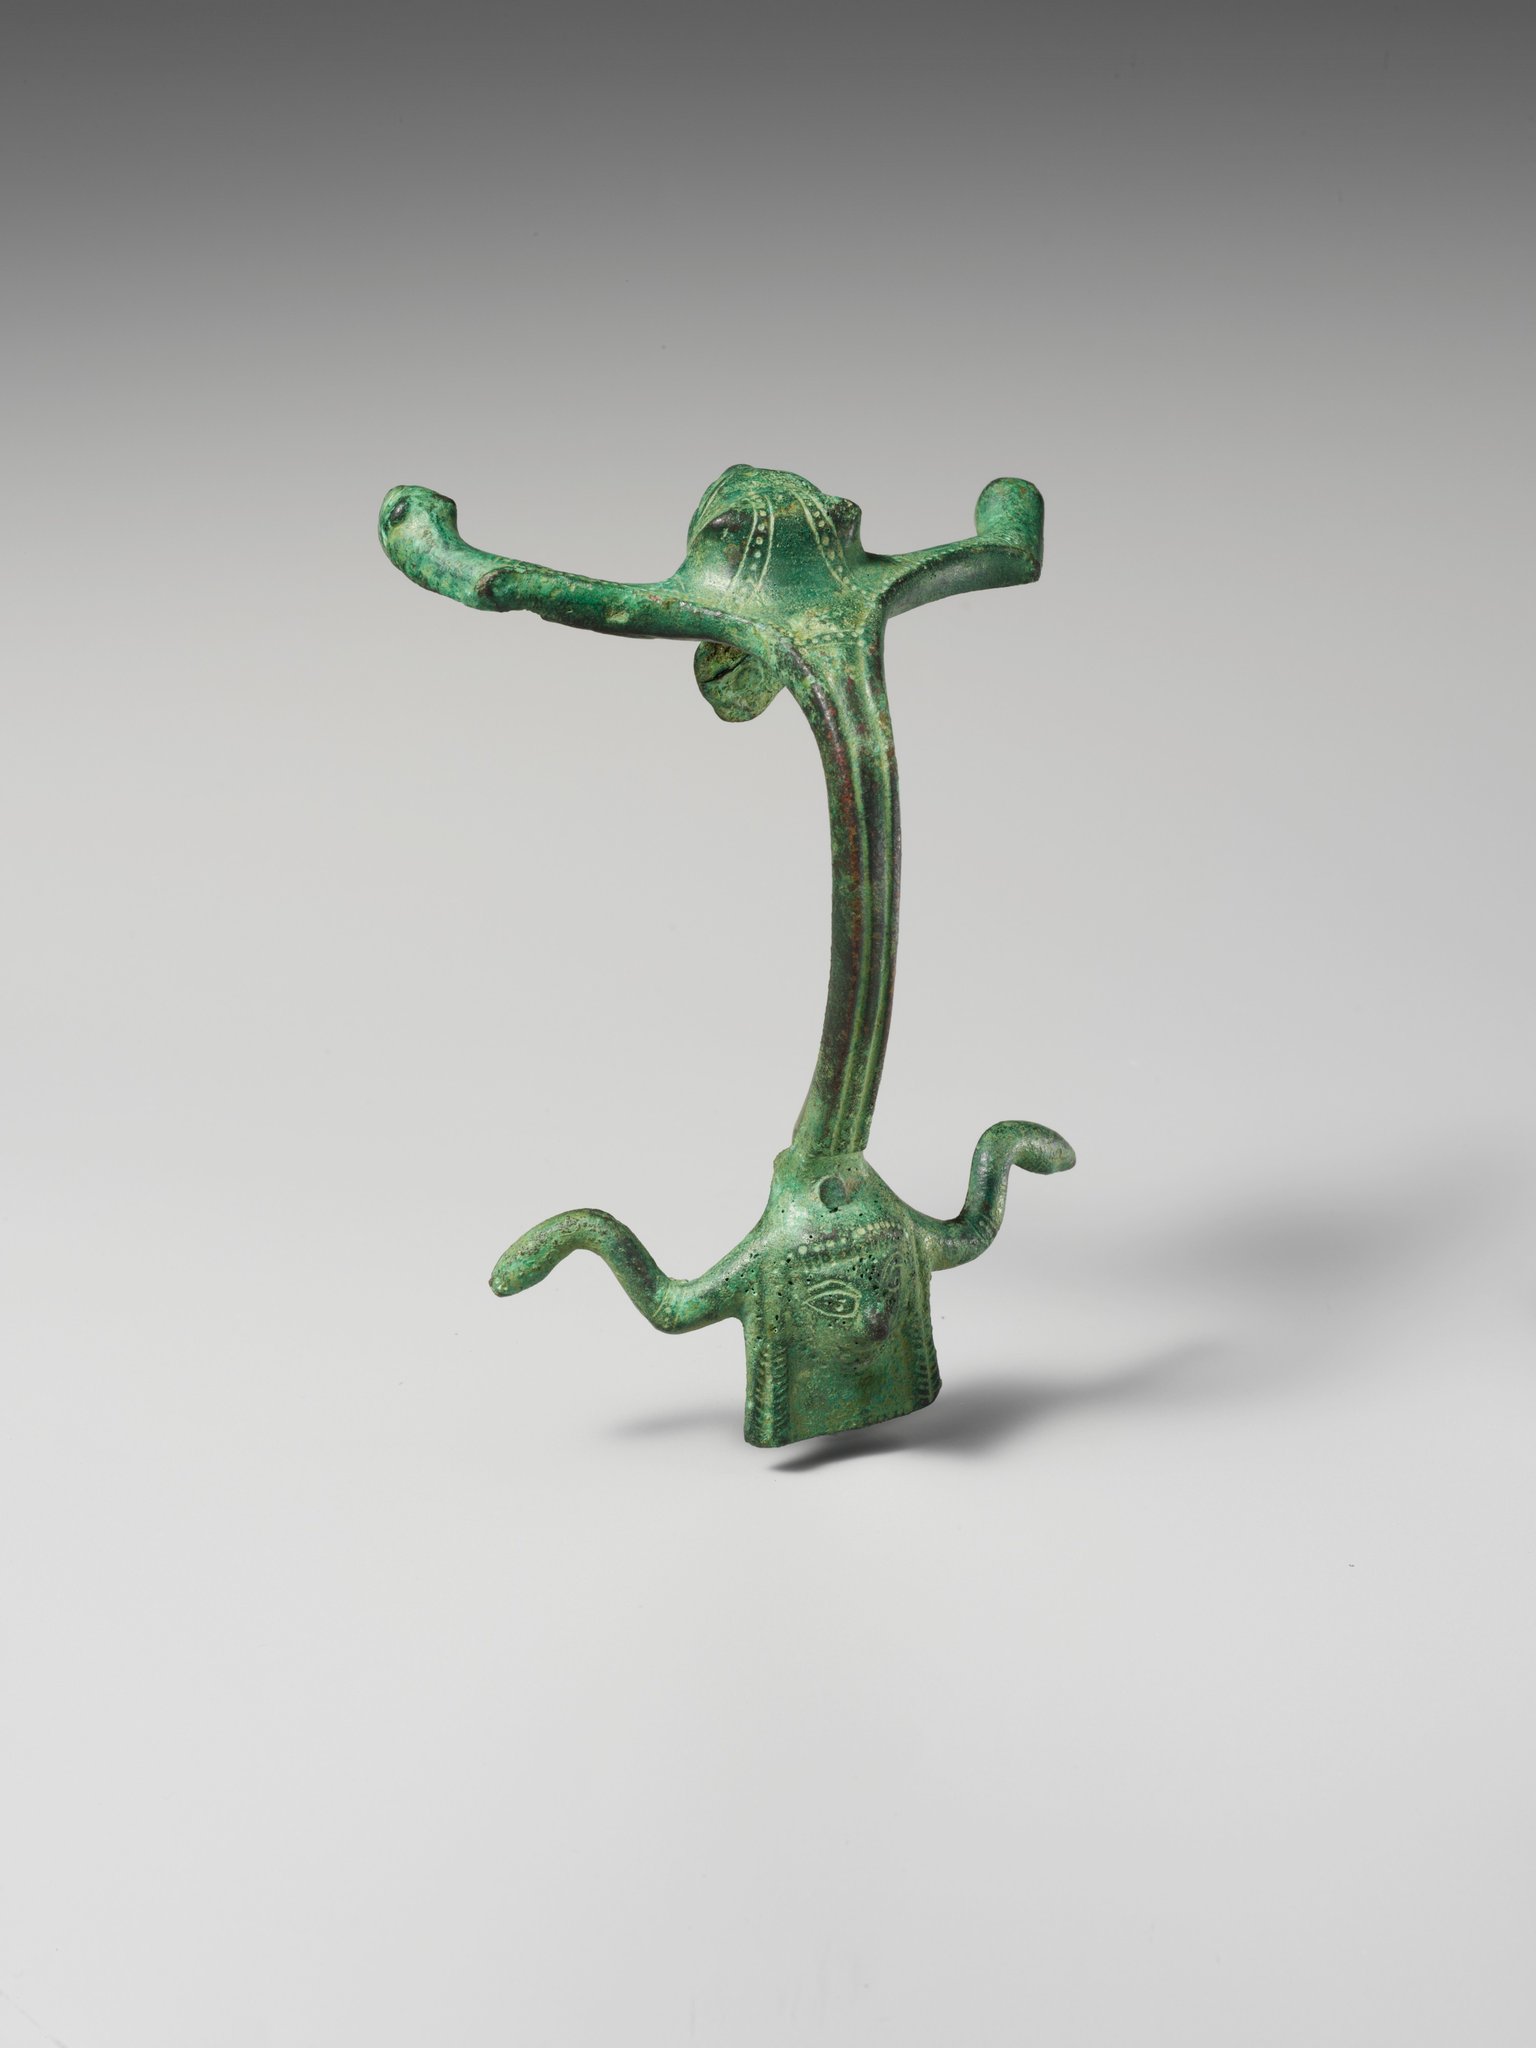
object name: handle of an oinochoe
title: Bronze oinochoe (jug) handle with lion's head and female protome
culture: etruscan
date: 600-501 BCE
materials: bronze